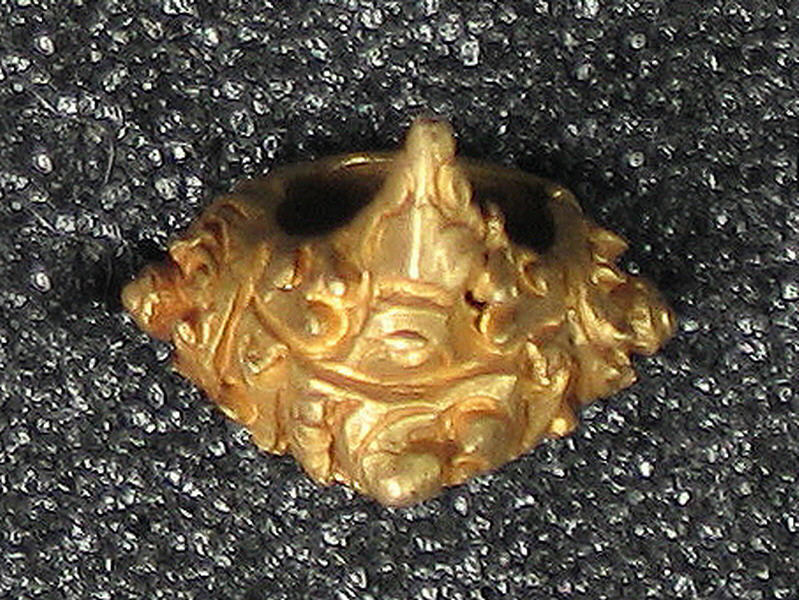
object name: earring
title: Earring cast with Mount Meru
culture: indonesian, central java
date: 701-1200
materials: gold